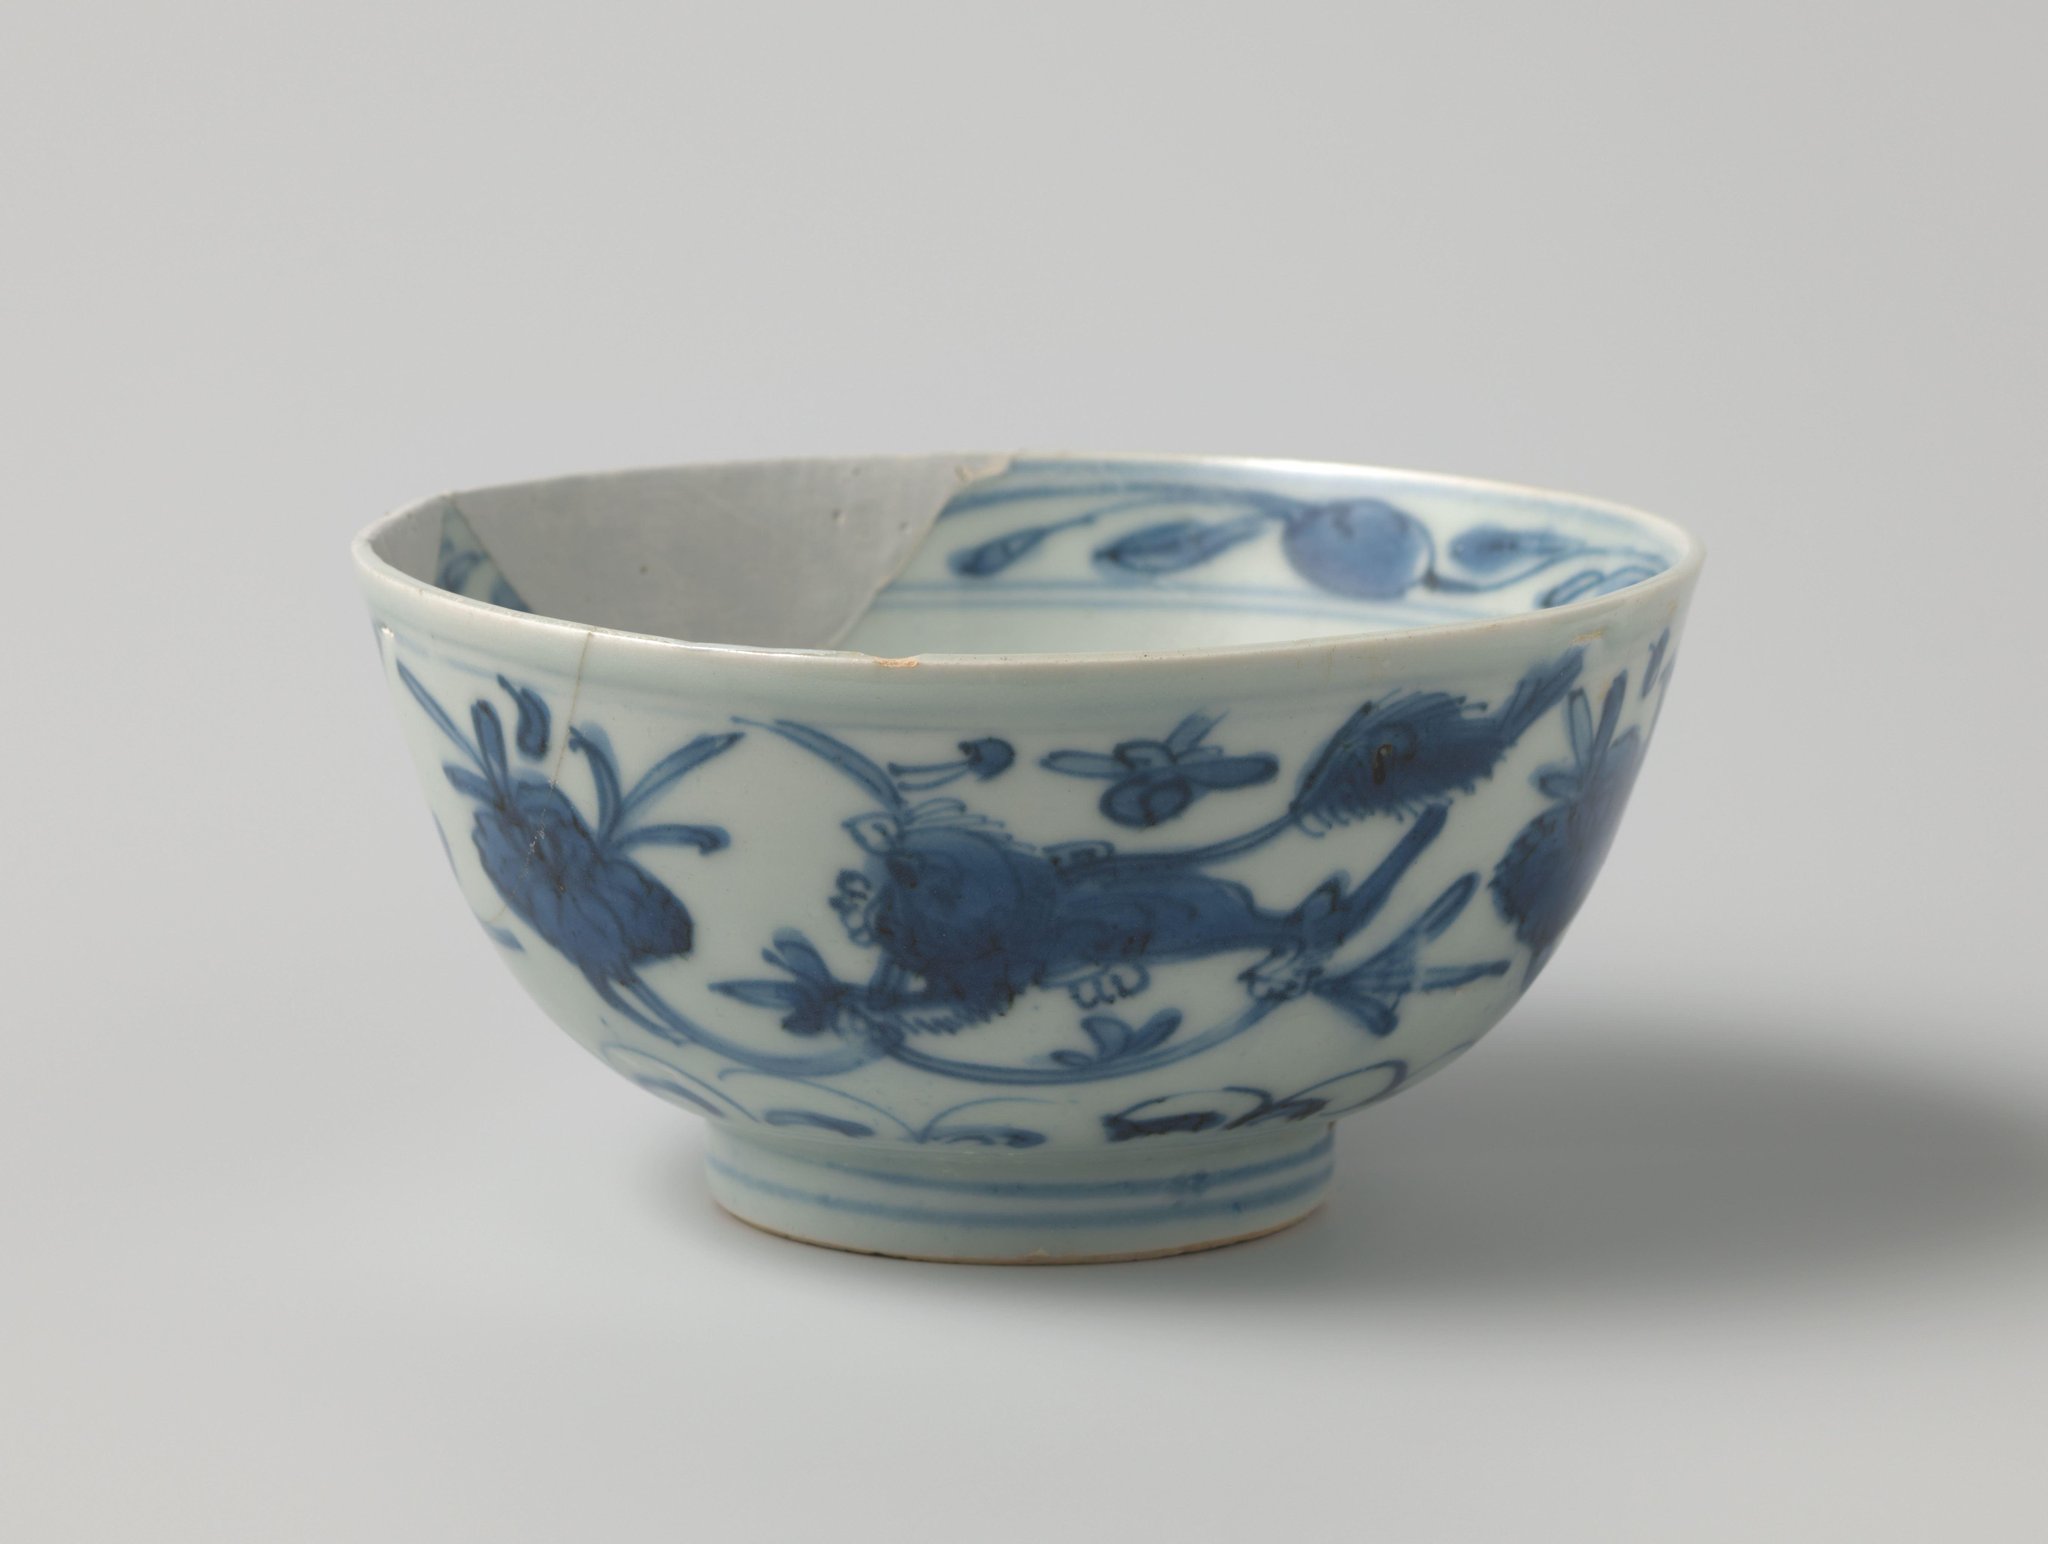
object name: bowl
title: Kom uit V.O.C.-schip de 'Witte Leeuw'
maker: Anonymous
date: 1613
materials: porcelain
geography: jingdezhen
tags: verenigde oostindische compagnie, sint-helena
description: A bowl. In the centre a motive is drawn encircled by a band of short lotus panels. On the lip-rim a frieze of peaches with leaves is drawn. The outside wall is decorated with alternating twice: a lion dog (fu) and a scroll of peonies. Around the footring a band of half-circles is drawn.